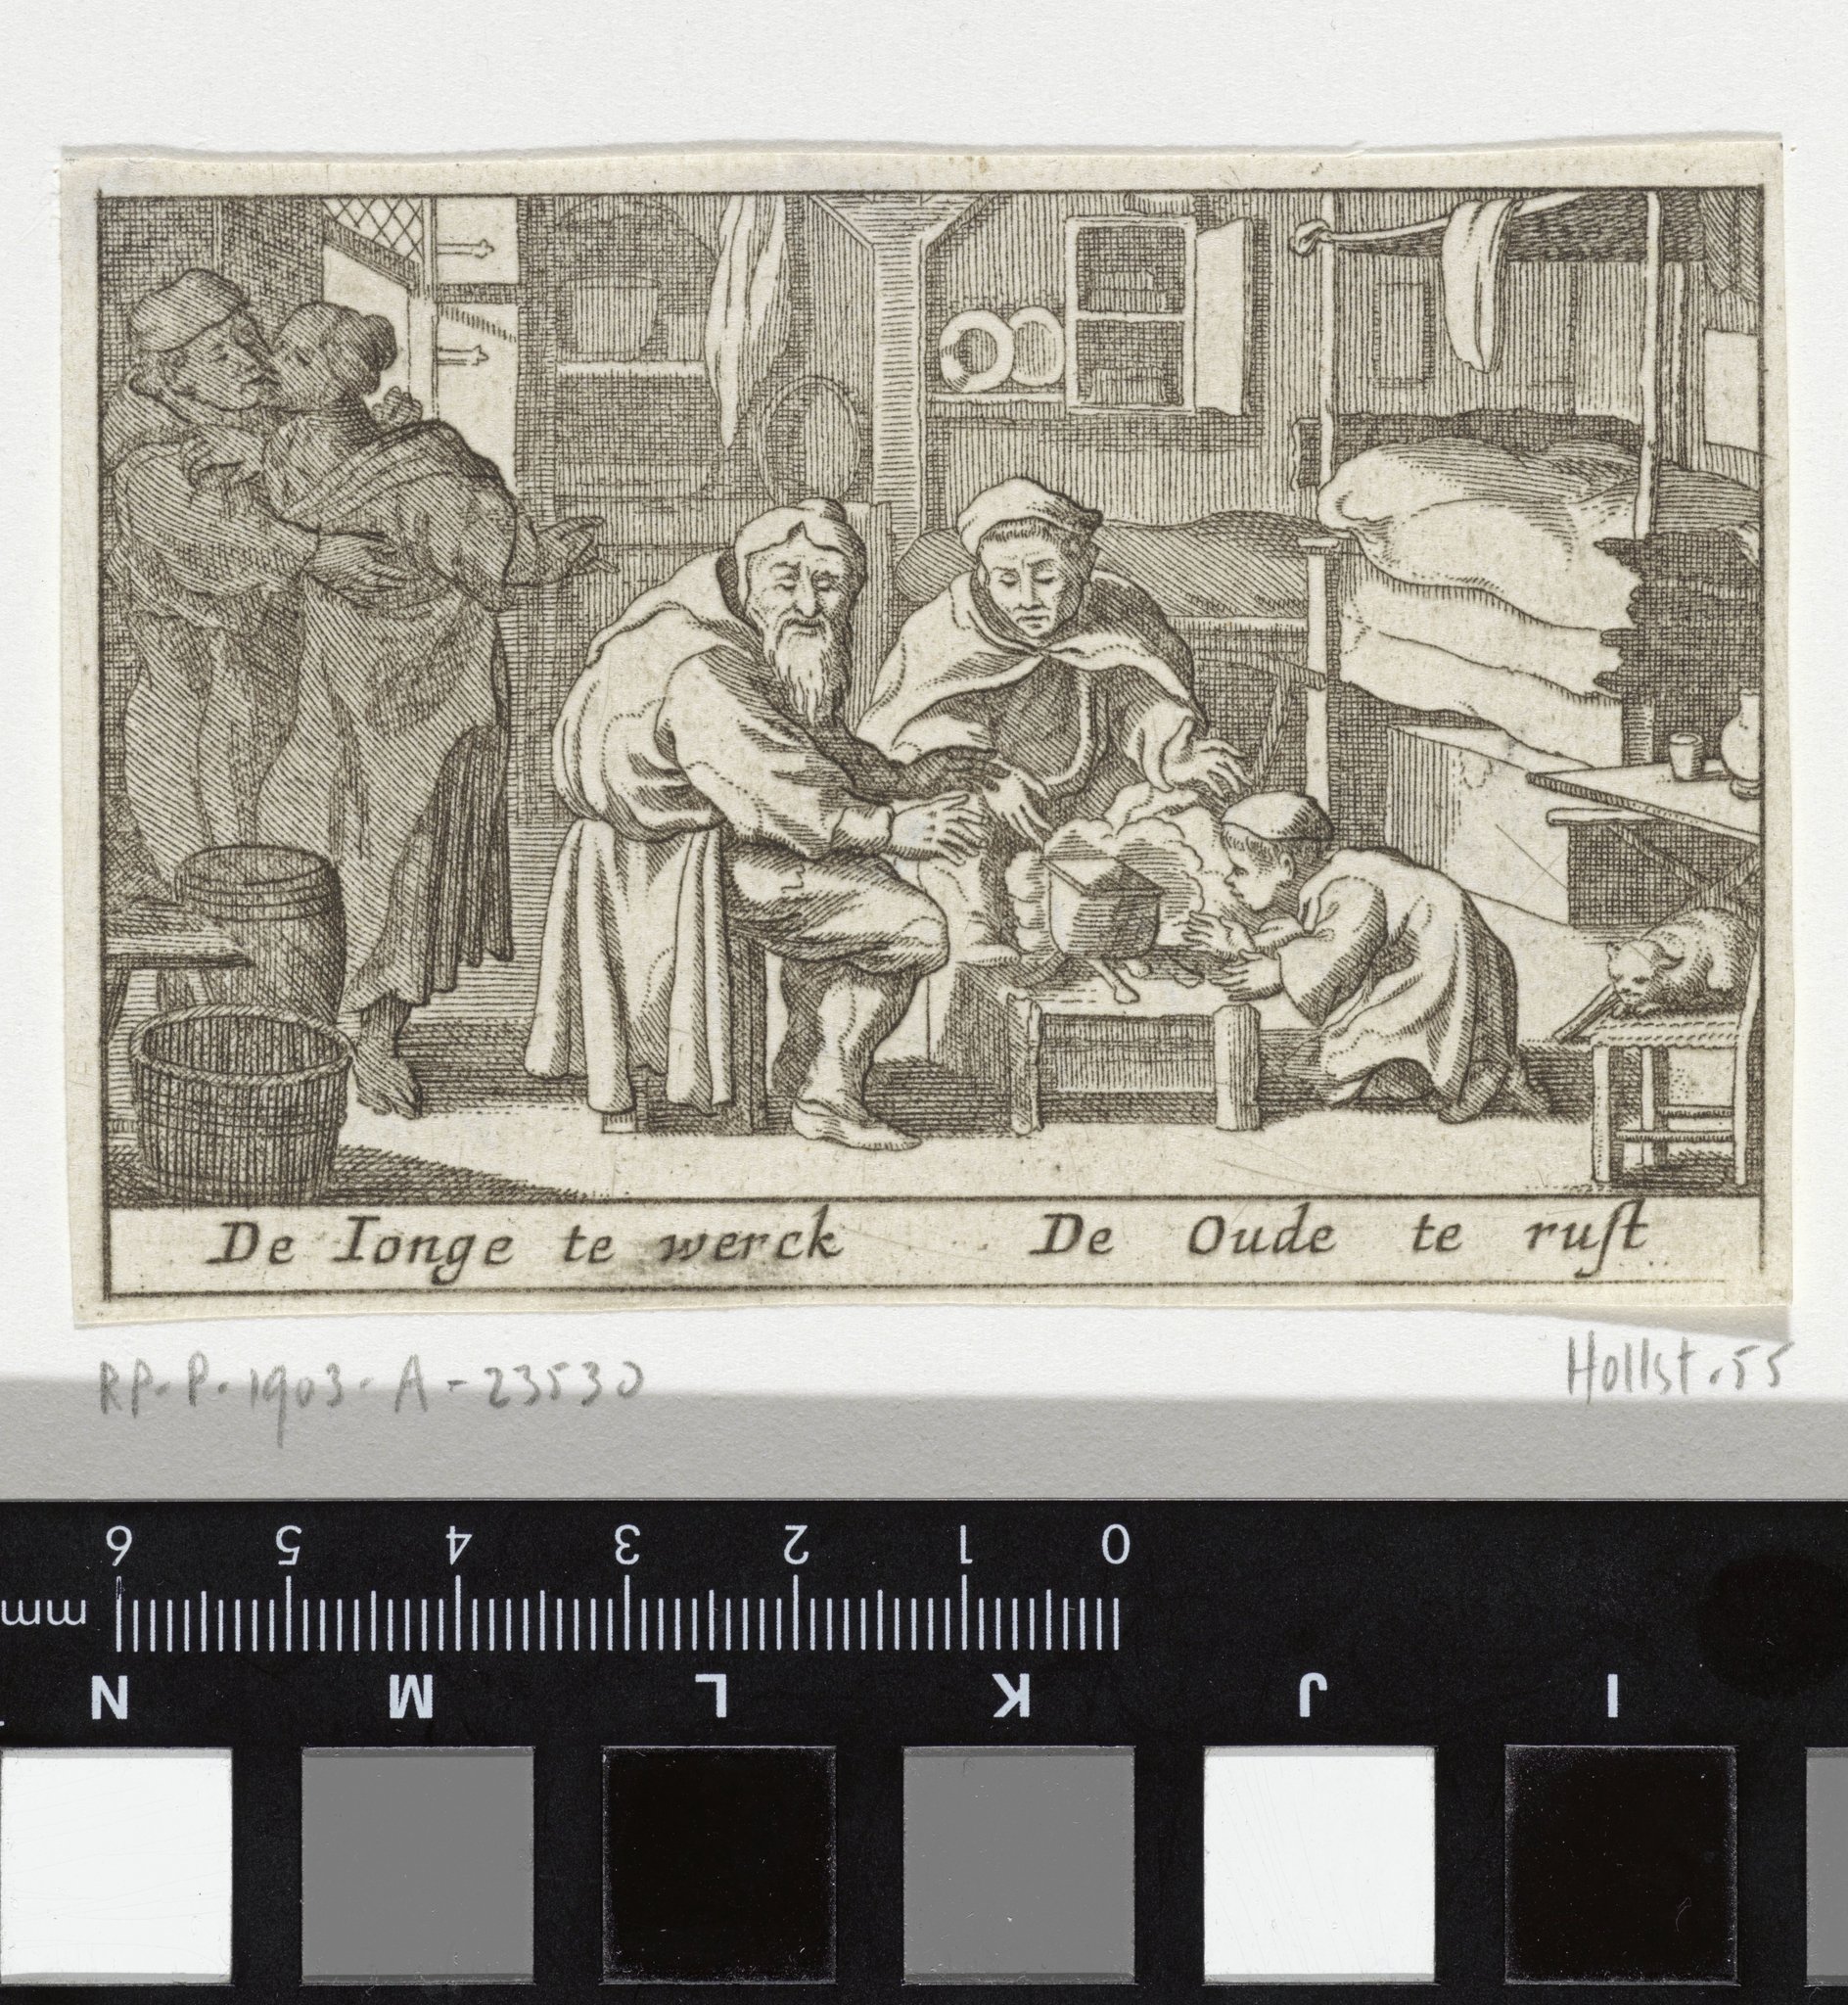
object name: print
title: Oud-Hollandse spreekwoorden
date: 1628-1650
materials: paper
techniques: etching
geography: amsterdam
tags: old man, open fire, fire-place, stove (in kitchen)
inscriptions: collector's mark: Lugt 2228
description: Twee oudere mannen zitten in een vertrek en warmen hun handen bij een vuurtje dat wordt aangeblazen door een kind. Links omhelst een jongeman een meisje.